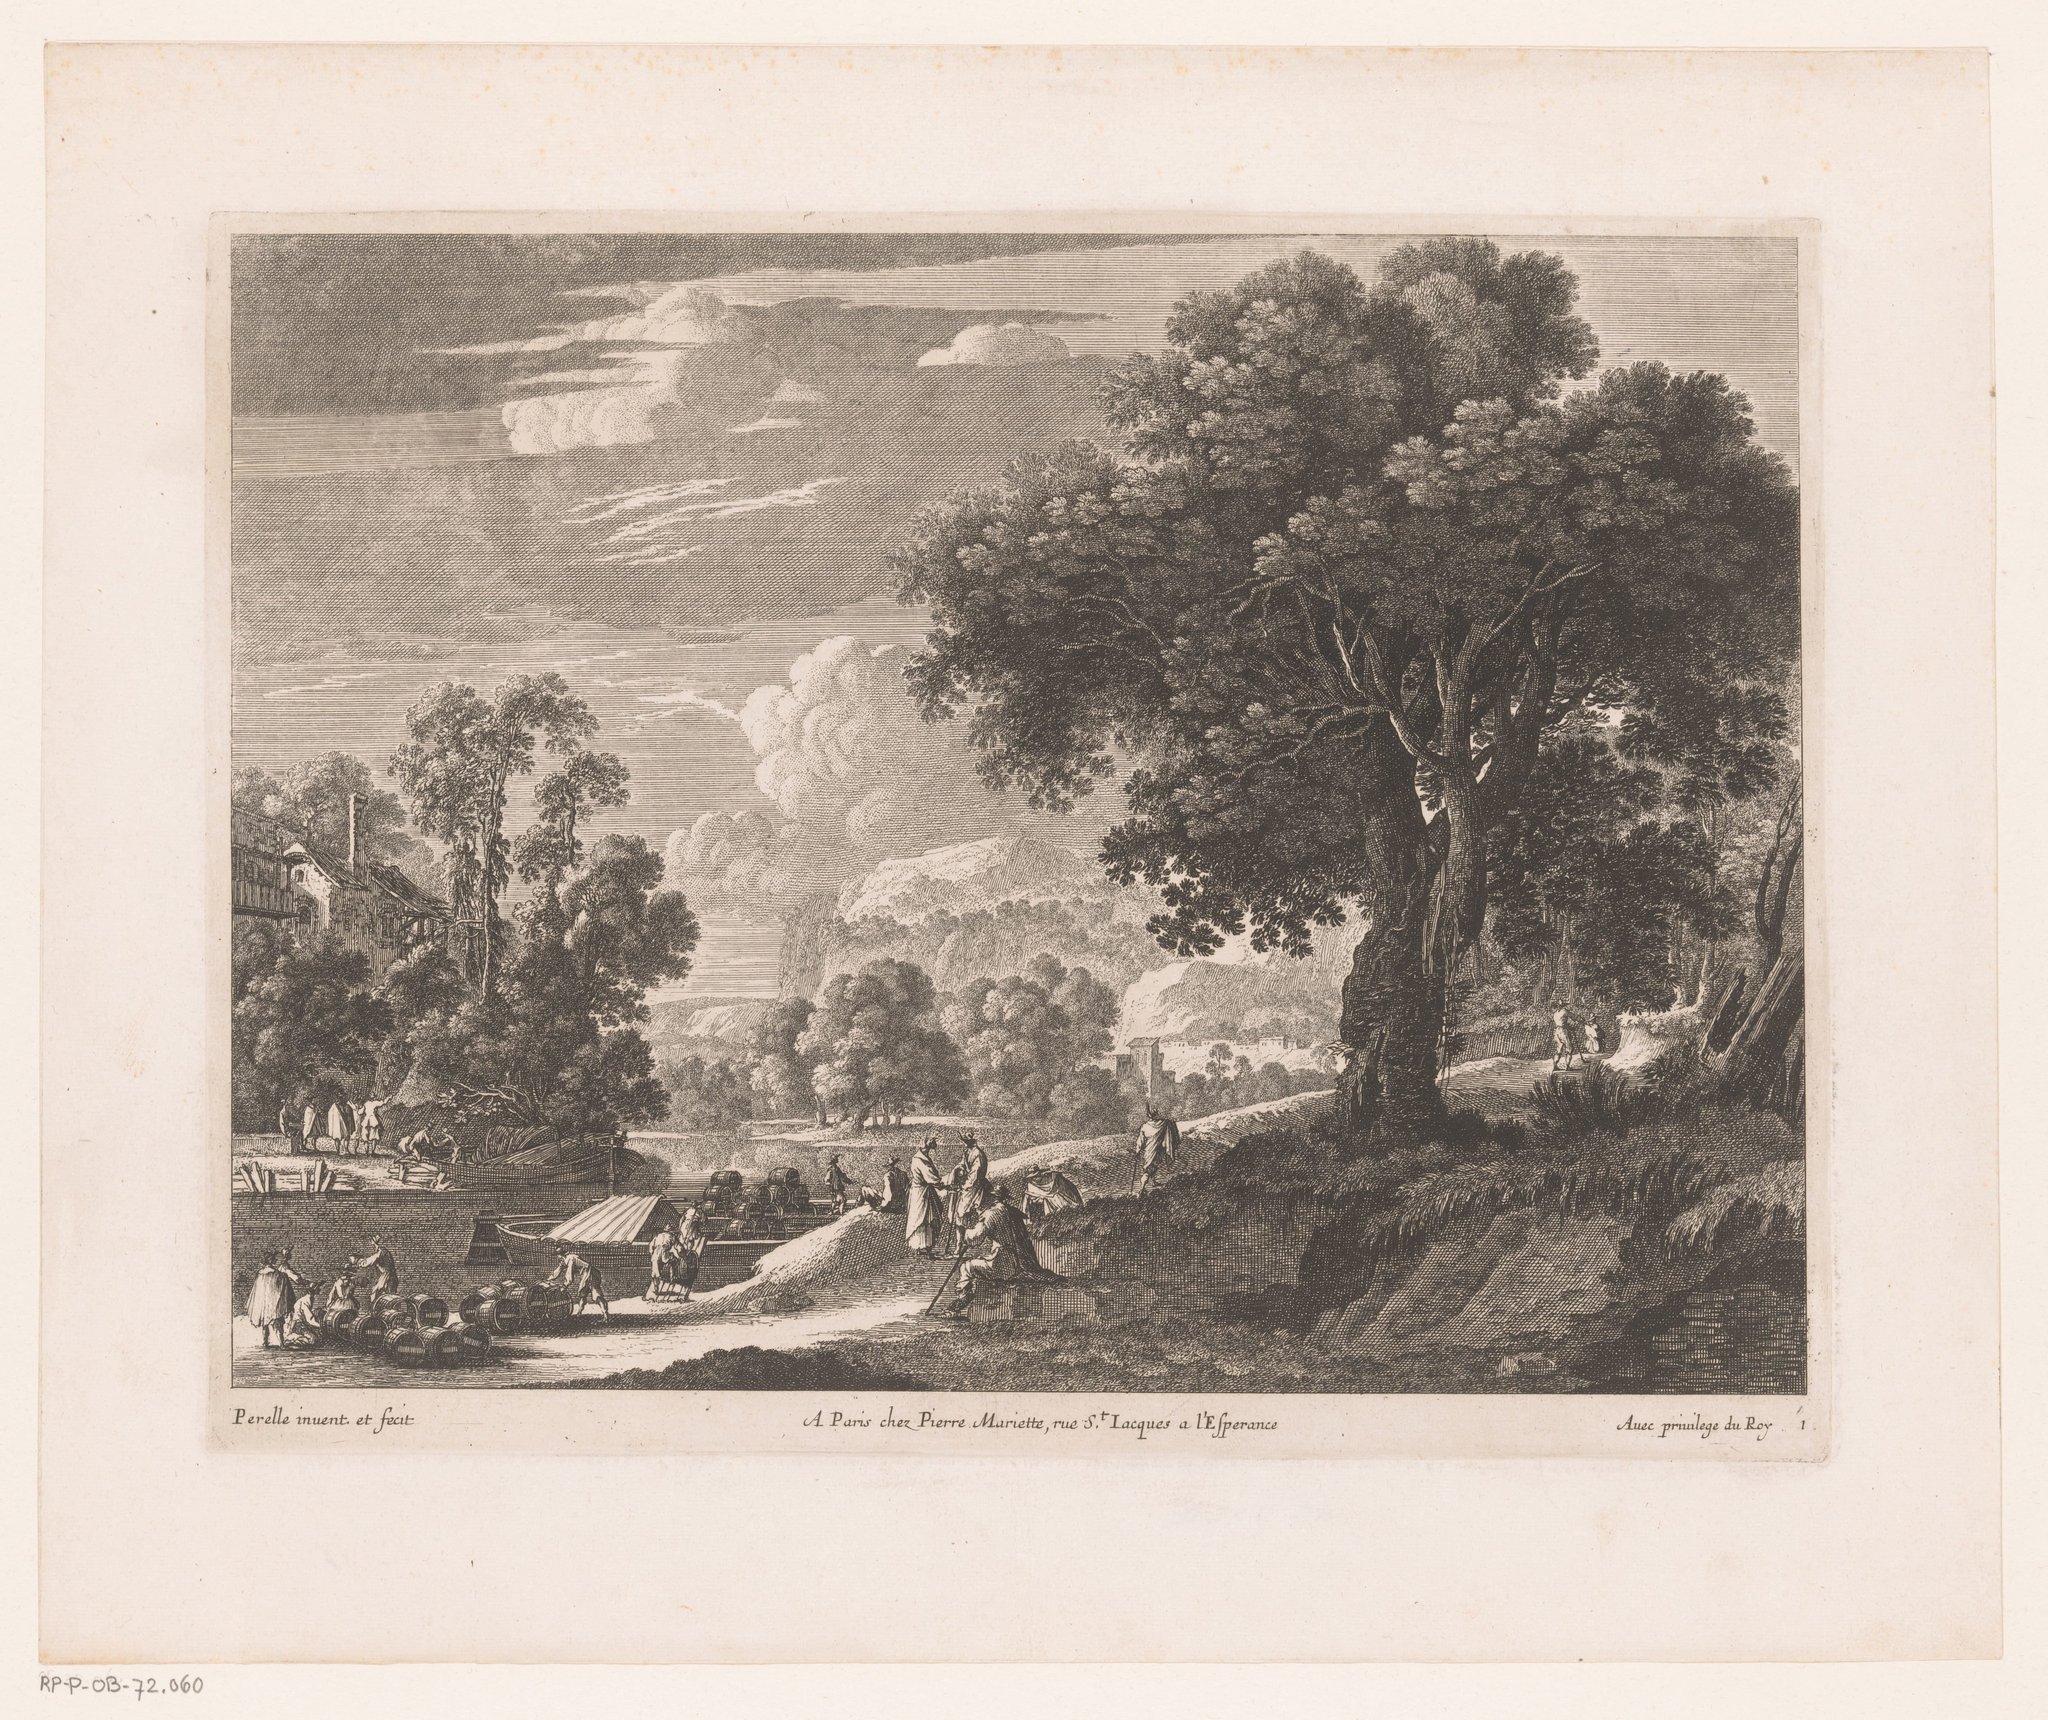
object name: print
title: Rivierlandschappen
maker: pierre mariette (i)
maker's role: print maker, publisher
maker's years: 1596-1657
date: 1613-1657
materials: paper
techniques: engraving, etching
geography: france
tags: river, traffic and transport (+ loading)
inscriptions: collector's mark: Lugt 240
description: Prenten met het signatuur 'Perelle' kunnen zowel door vader Gabriel als door zonen Nicolas en Adam gemaakt zijn.